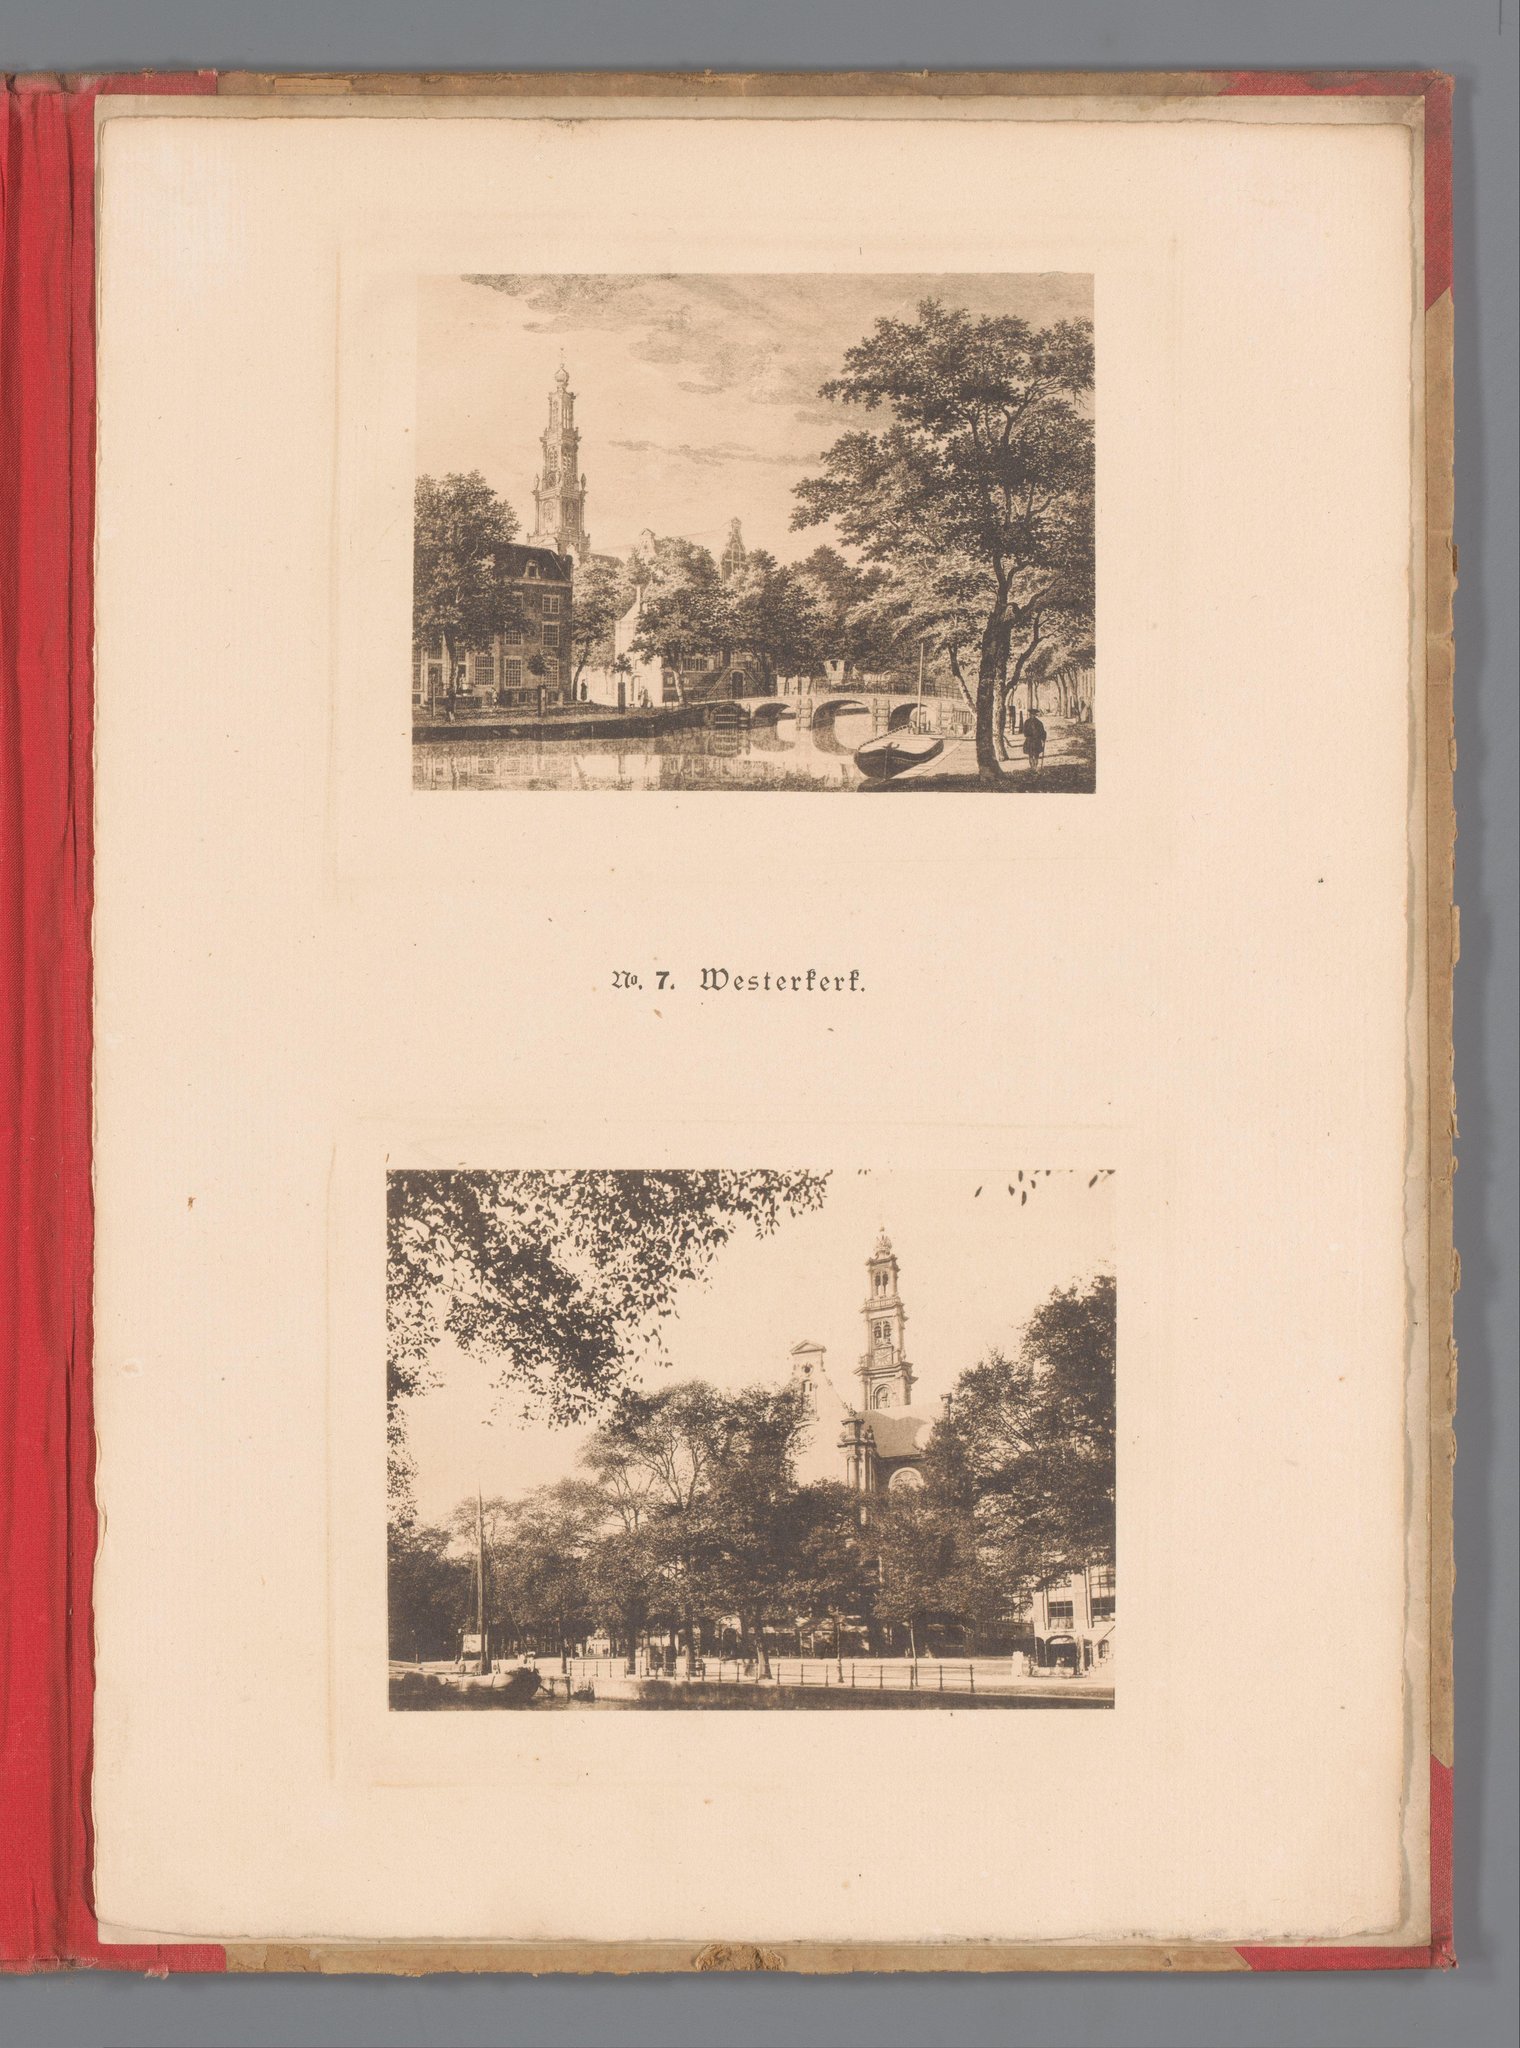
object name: reproduction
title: Twee gezichten op de Westerkerk Amsterdam, waarvan één reproductie van een prent door Paulus van Liender naar Jan de Beijer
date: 1890-1900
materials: paper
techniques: photograph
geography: amsterdam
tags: church (exterior), canals, waters (in city) (+ city(-scape) with figures, staffage)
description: Deze prenten maken deel uit van een album.